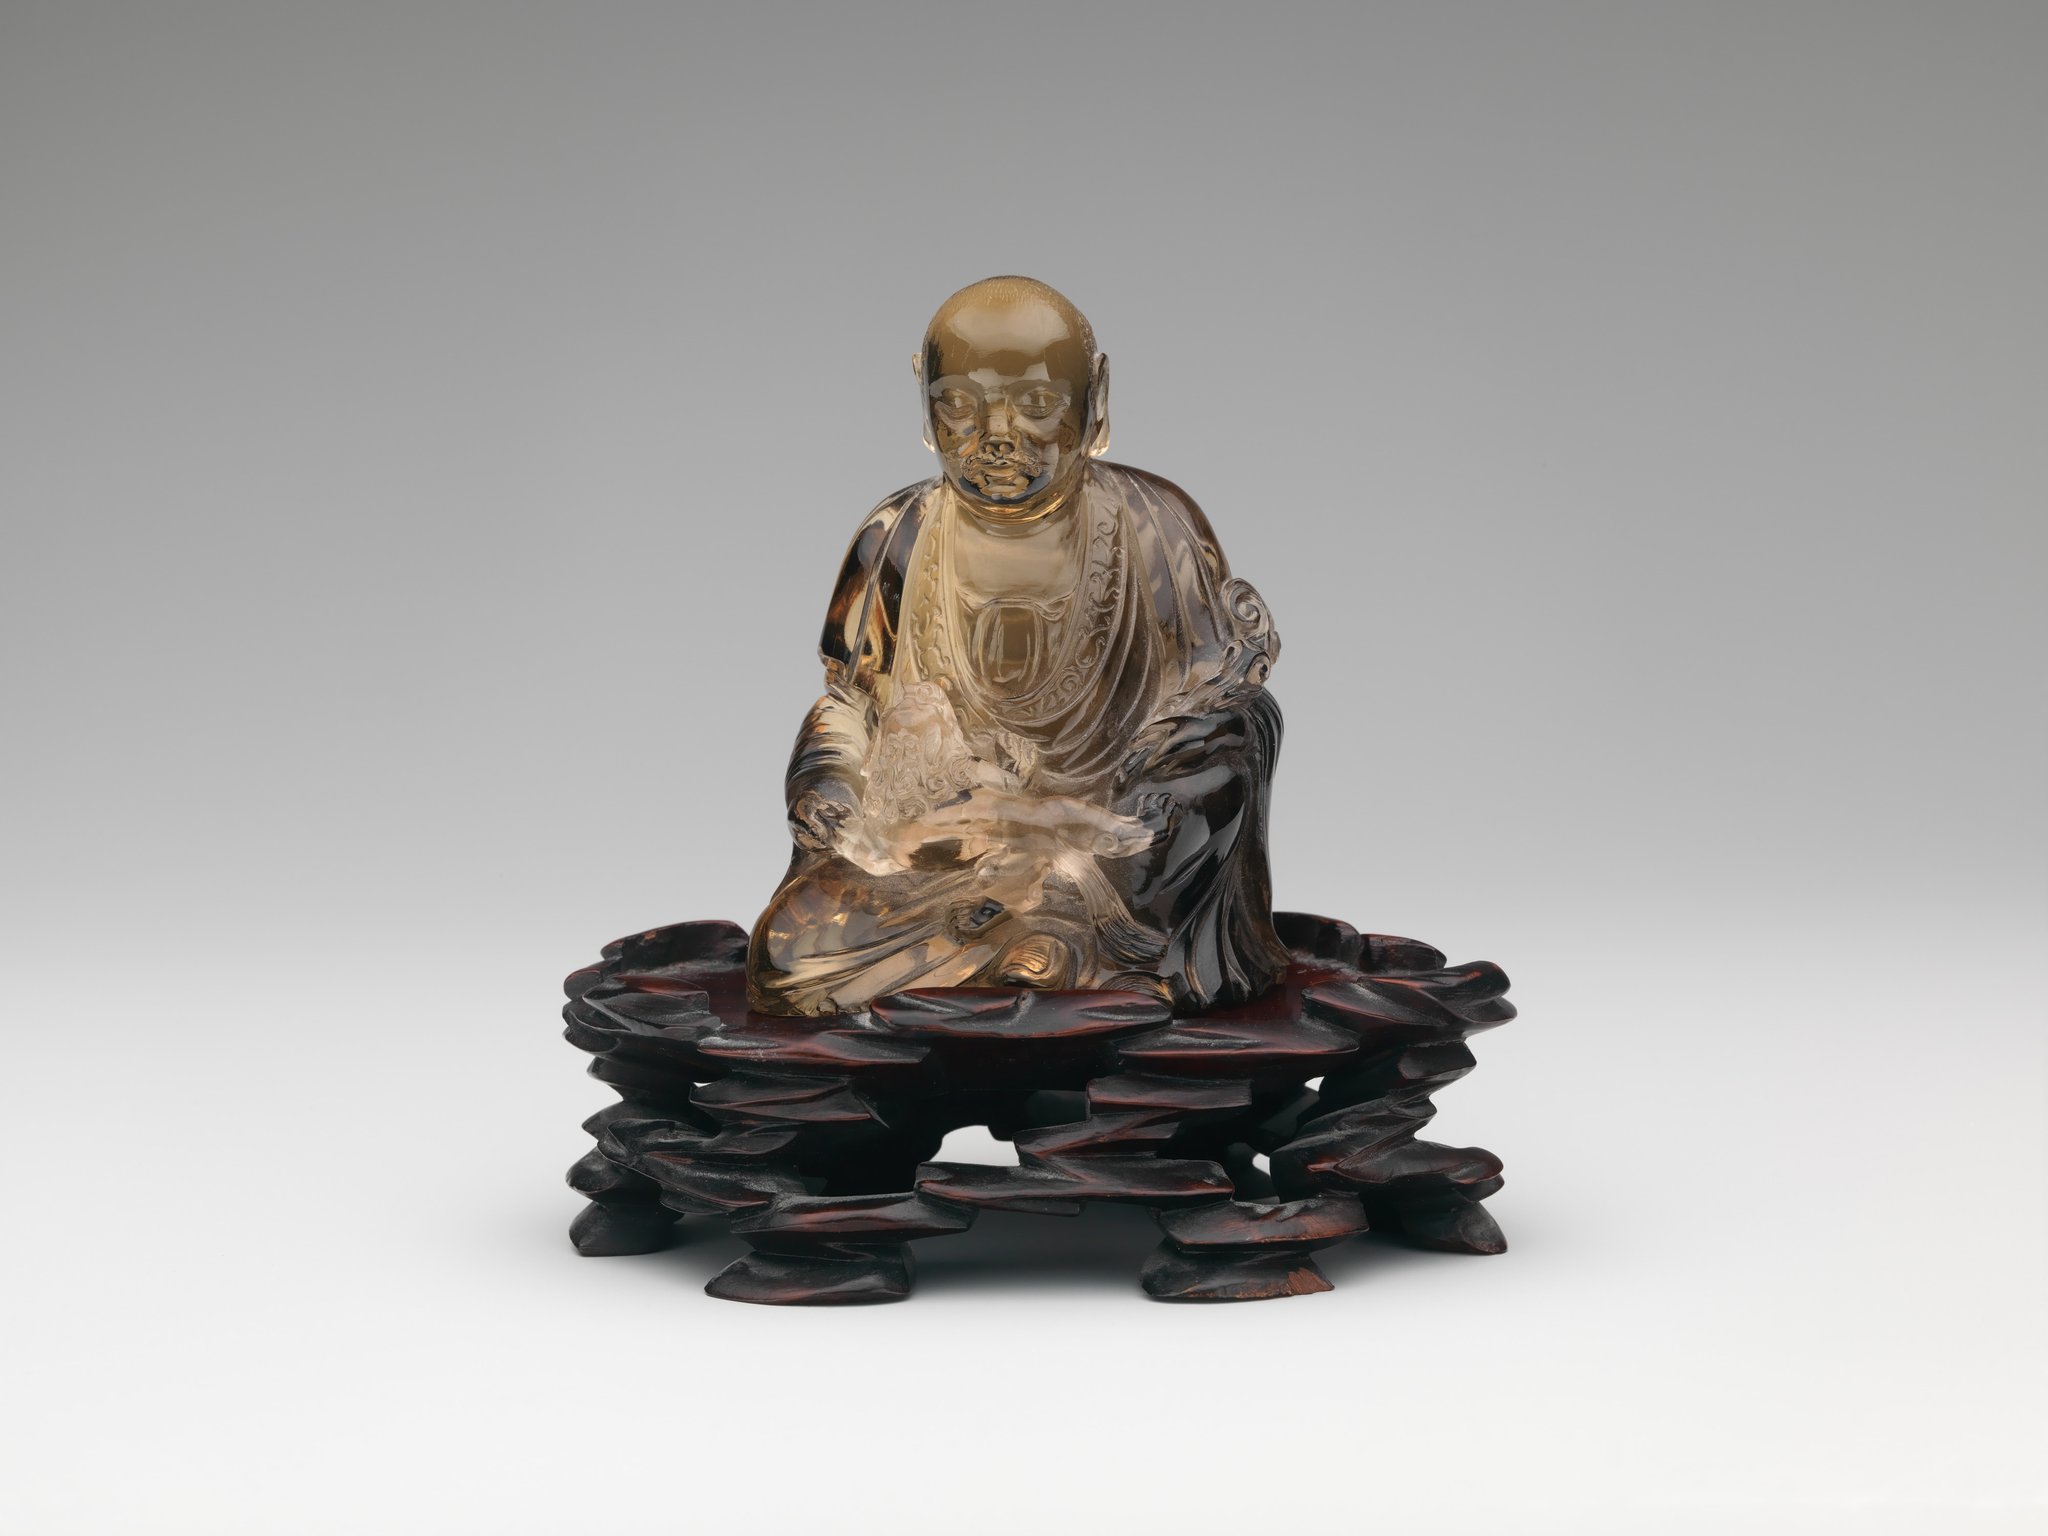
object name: figure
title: Luohan with a lion cub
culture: chinese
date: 1701-1800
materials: quartz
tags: men